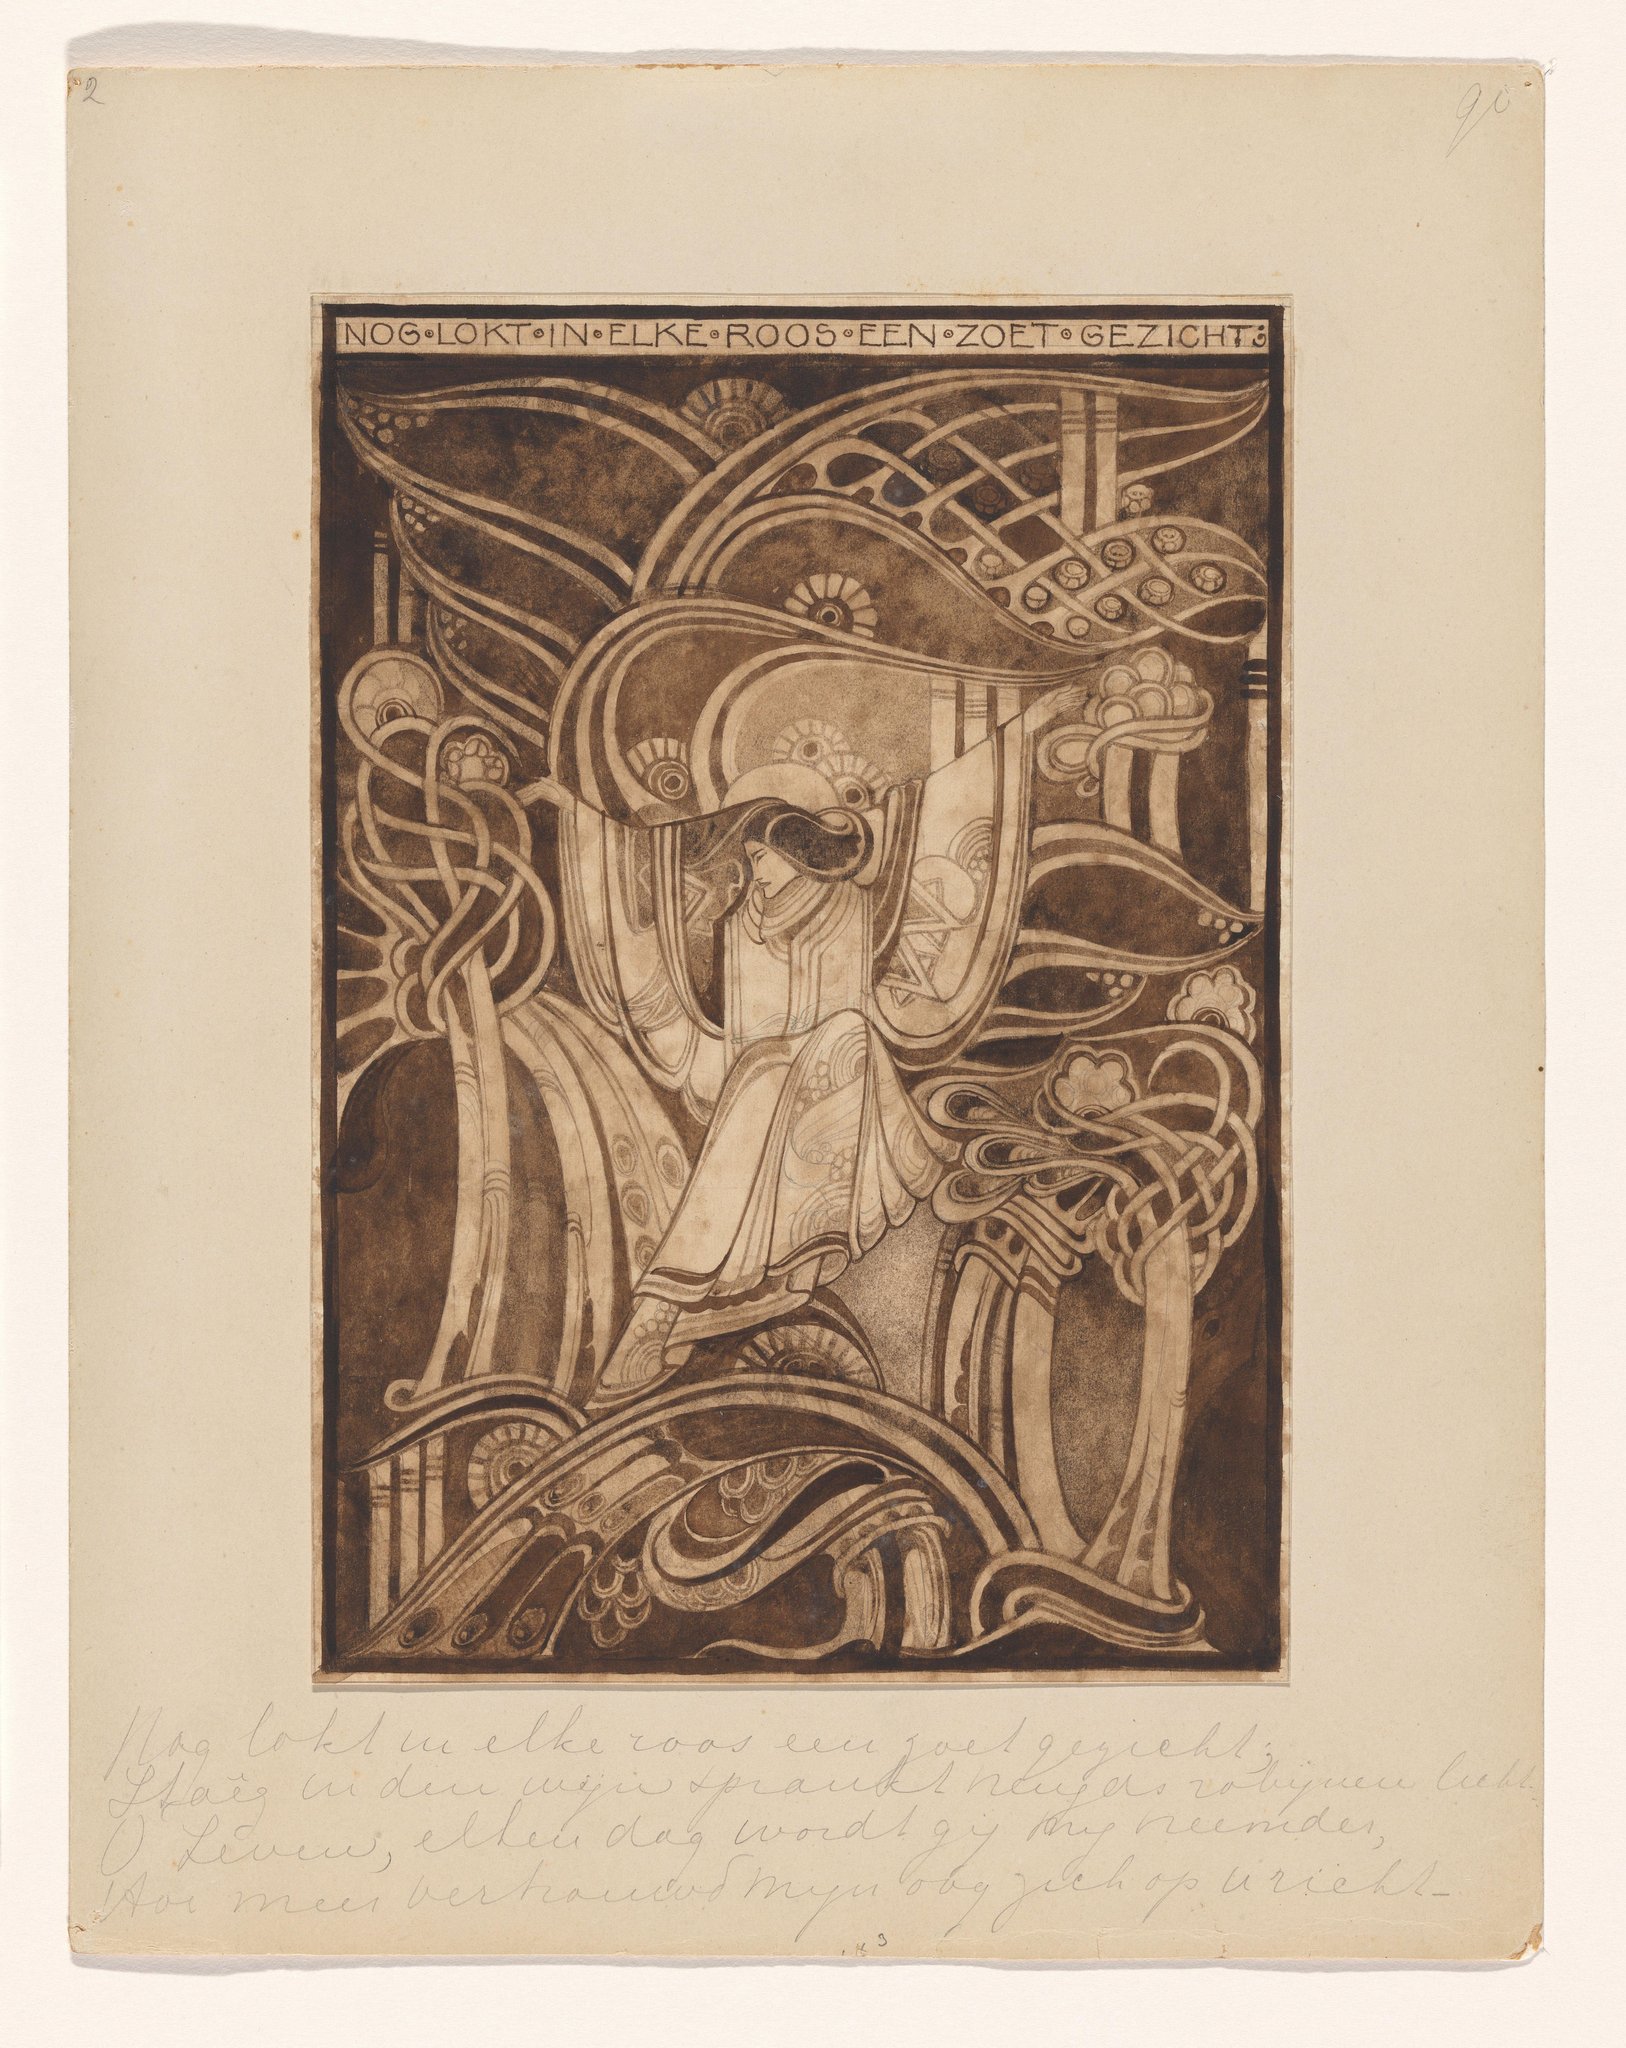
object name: drawing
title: Nog lokt in elke roos een zoet gezicht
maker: willem arondéus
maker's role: draughtsman, print maker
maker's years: 1894-1943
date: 1914-1920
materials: cardboard, ink, paper, pencil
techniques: brush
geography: netherlands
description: Tekening naar de Rubaiyat van Omar Khayyam.